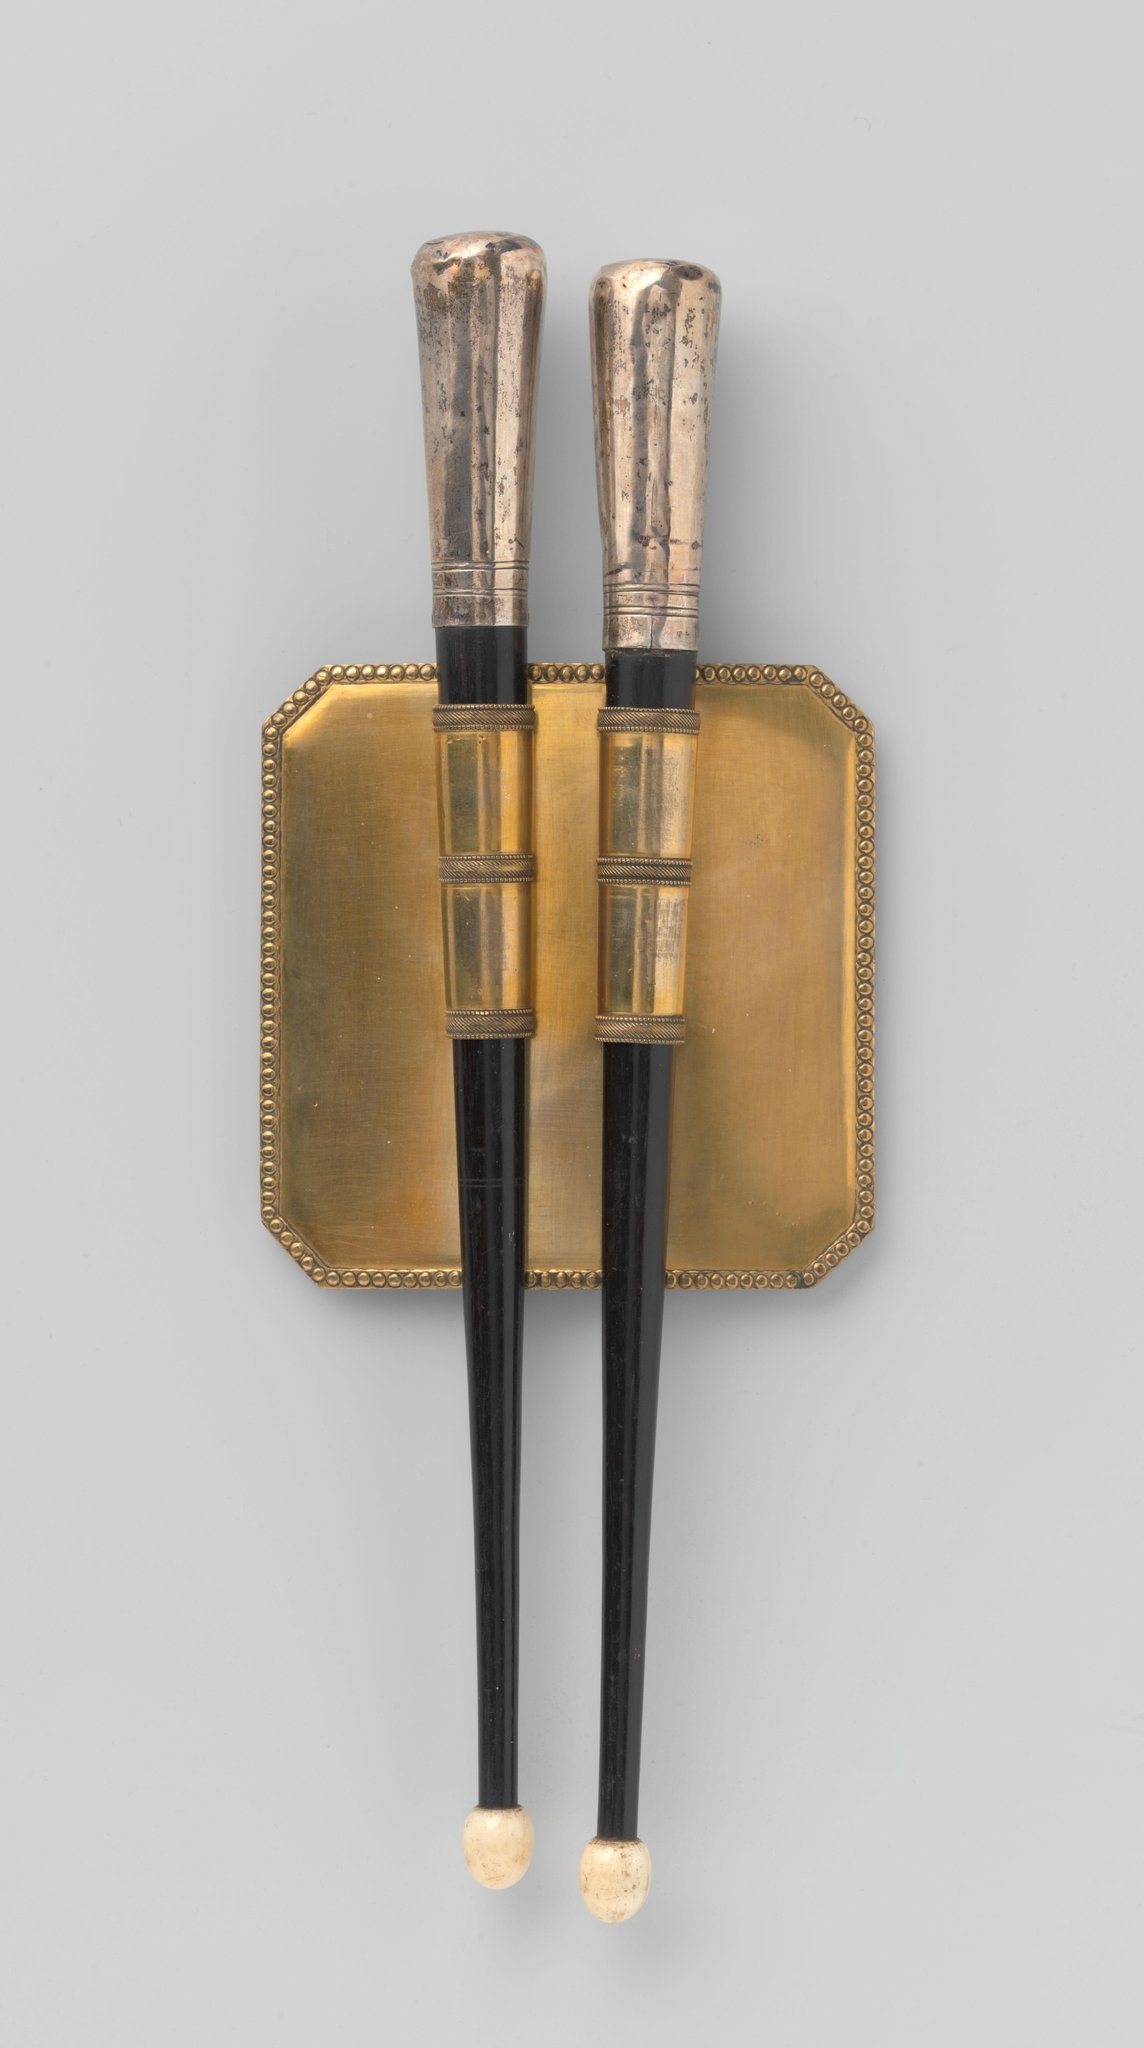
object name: element of musical instrument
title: Drumsticks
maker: Anonymous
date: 1817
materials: wood, ivory, silver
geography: netherlands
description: Een ebbenhouten tromstok met ivoren knop.